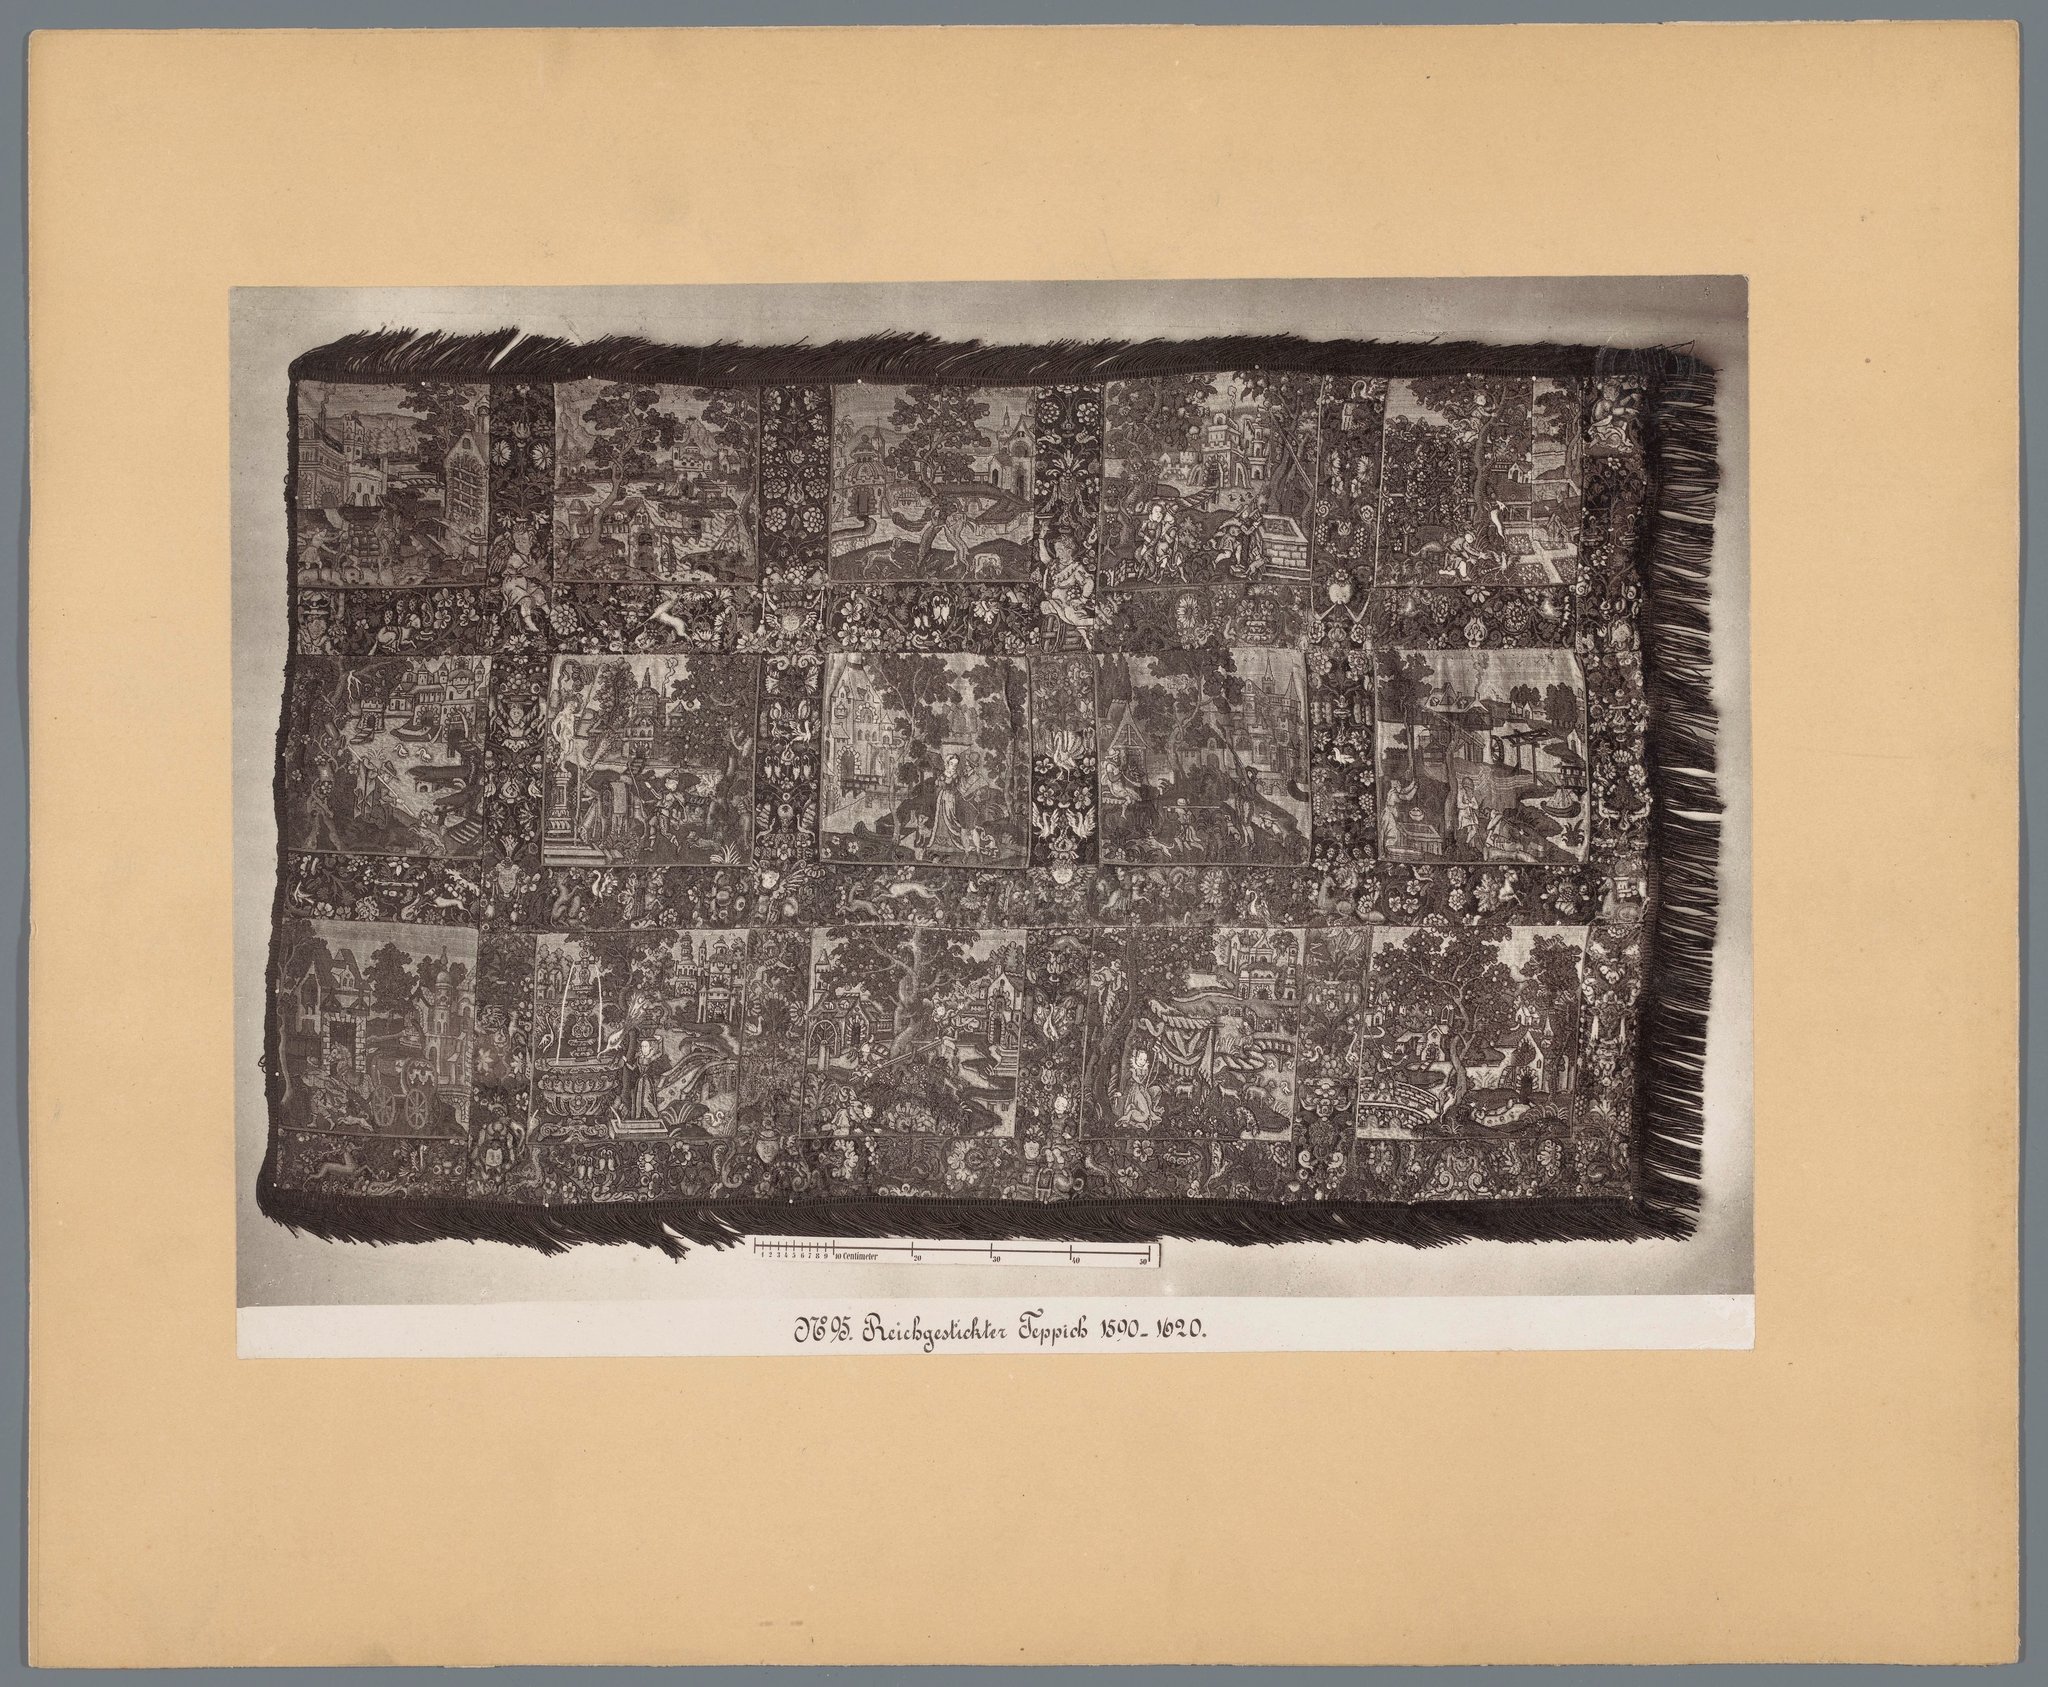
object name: photograph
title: Tapijt gedecoreerd met vijftien verhalende voorstellingen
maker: Anonymous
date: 1875-1900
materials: cardboard, paper, ink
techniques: photograph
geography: europe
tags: tapestry, europe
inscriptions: number: ‘No 95.’, inscription: ‘[...]res national musee [...]’, collector's mark: Lugt 3937